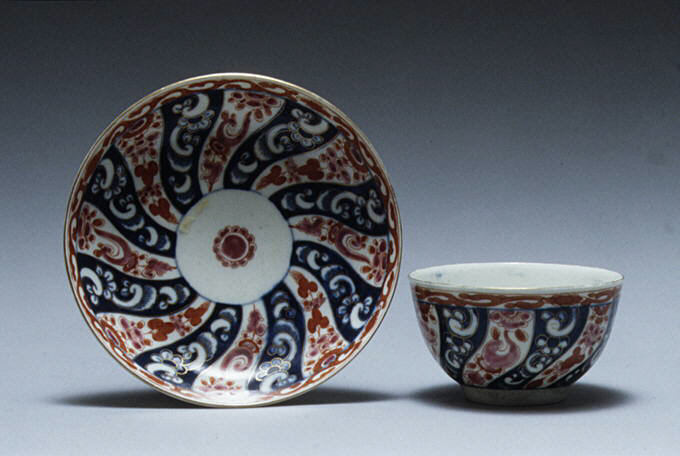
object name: teabowl and saucer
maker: worcester factory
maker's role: factory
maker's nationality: british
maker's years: 1751-2008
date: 1770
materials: soft paste porcelain